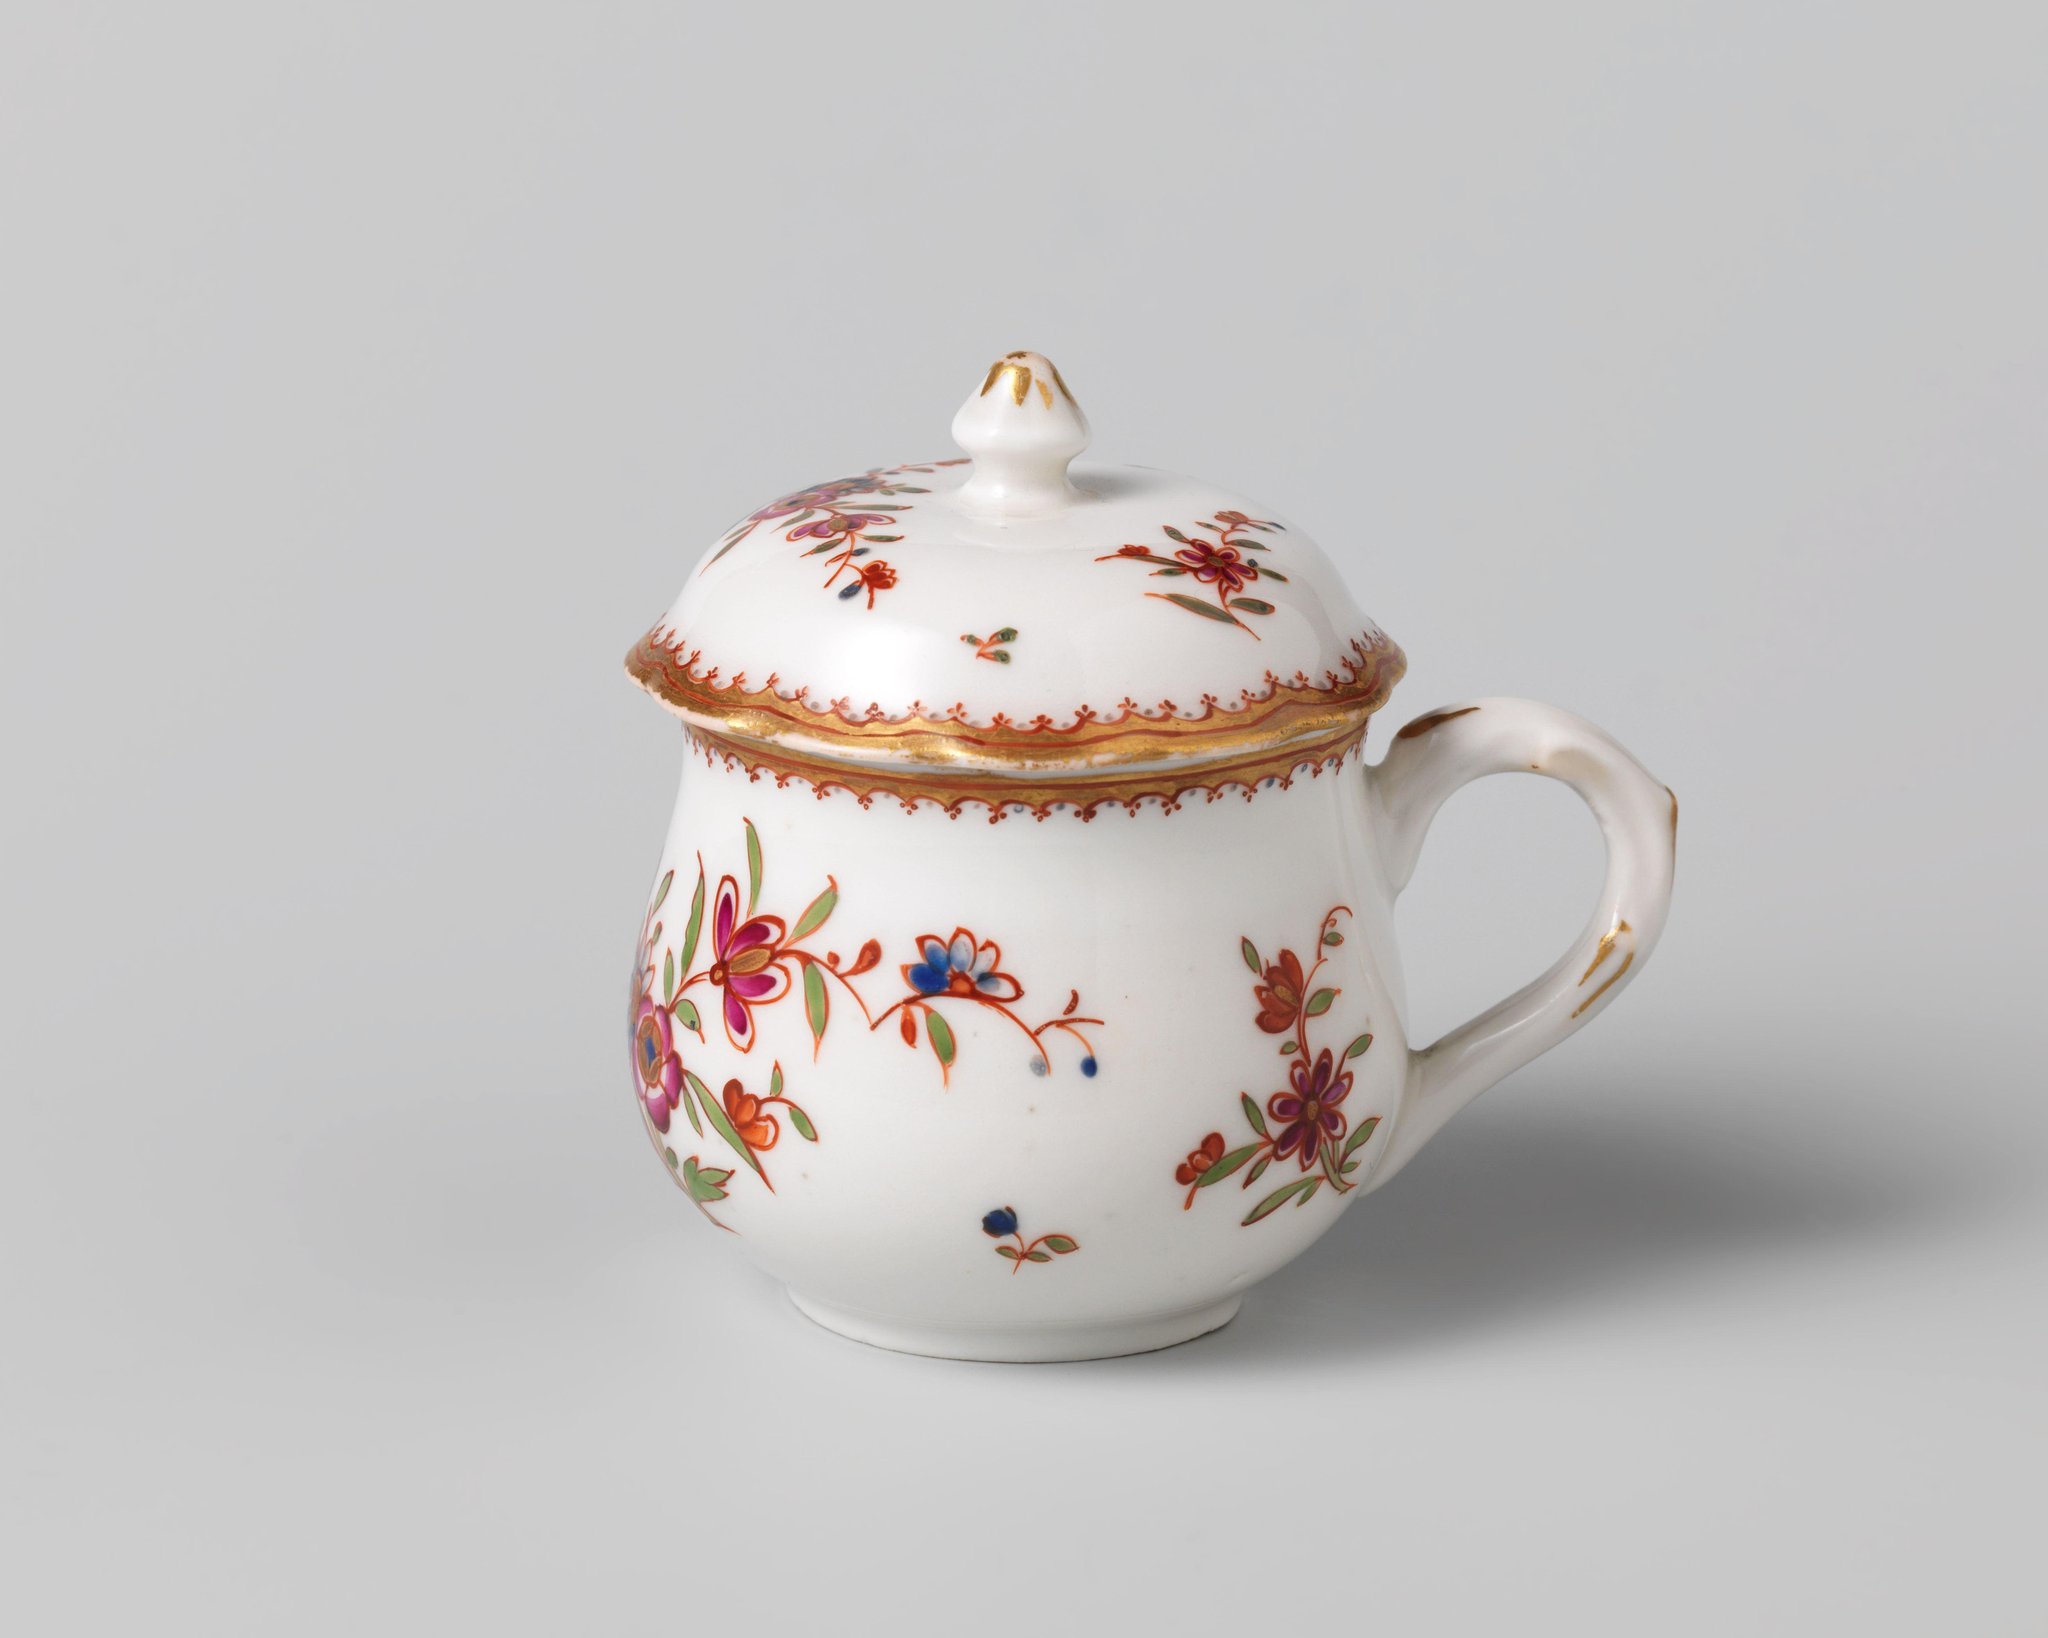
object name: roompot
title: Crèmepot, beschilderd met 'Indianische Blumen'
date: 1778-1782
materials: porcelain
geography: loosdrecht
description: Two cream pots. Porcelain. Loosdrecht, c. 1778 - 1782. Factory of Joannes de Mol.